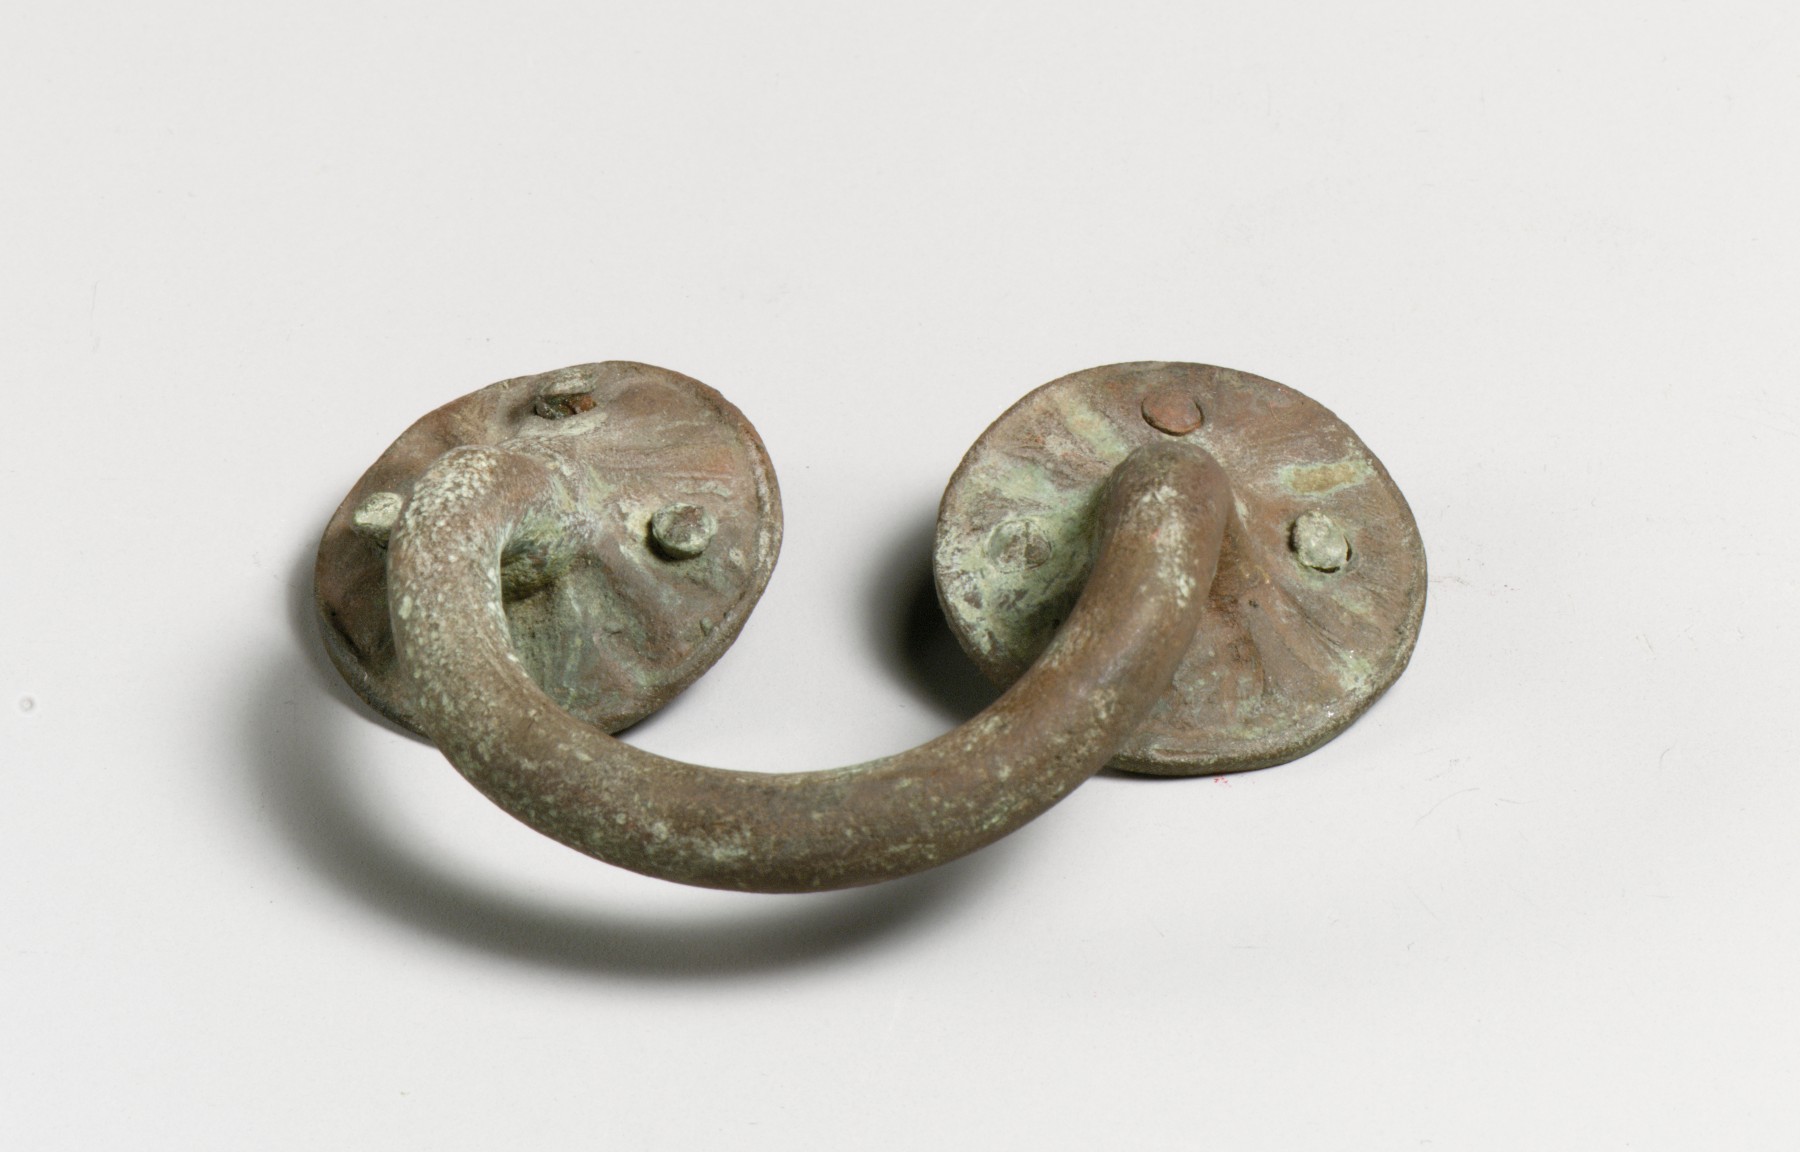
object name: handle of a hydria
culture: cypriot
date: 500-301 BCE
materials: bronze